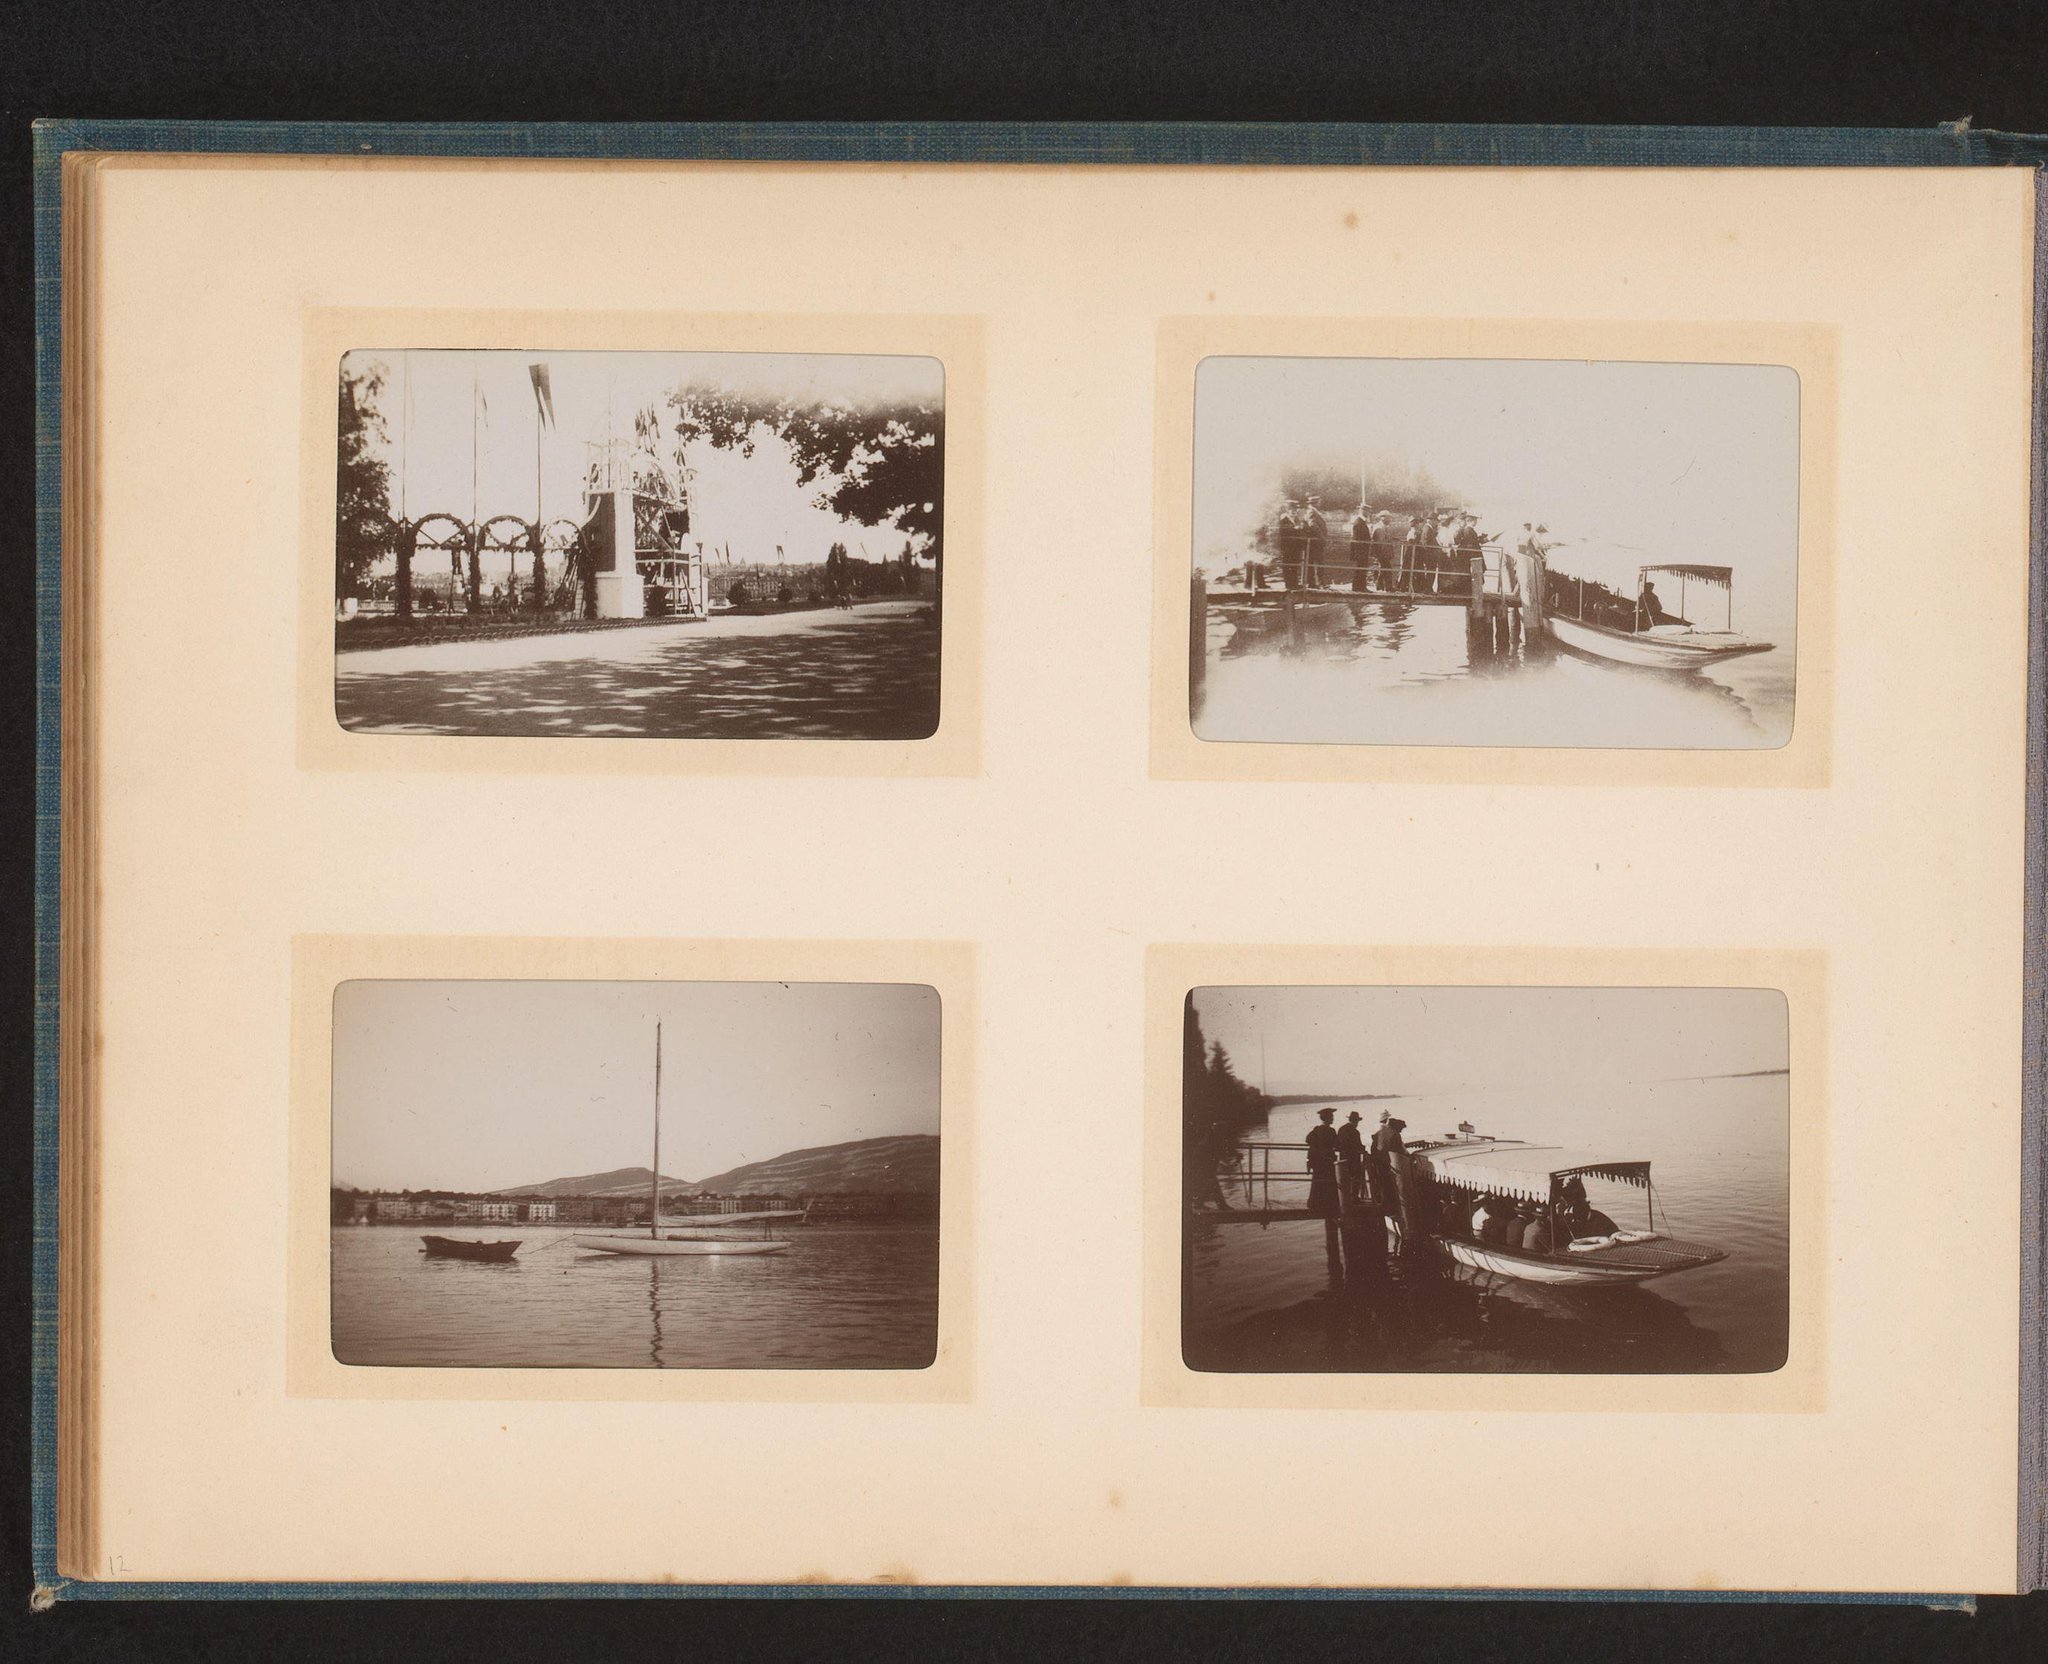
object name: photograph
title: Drie landschappen met water te Frankijk en Gezicht op een toegangspoort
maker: Anonymous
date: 1900-1915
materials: paper, photographic support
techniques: gelatin silver print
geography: france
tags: landscapes with waters, waterscapes, seascapes (in the temperate zone), ships (in general), gate, entrance, travelling; tourism, france